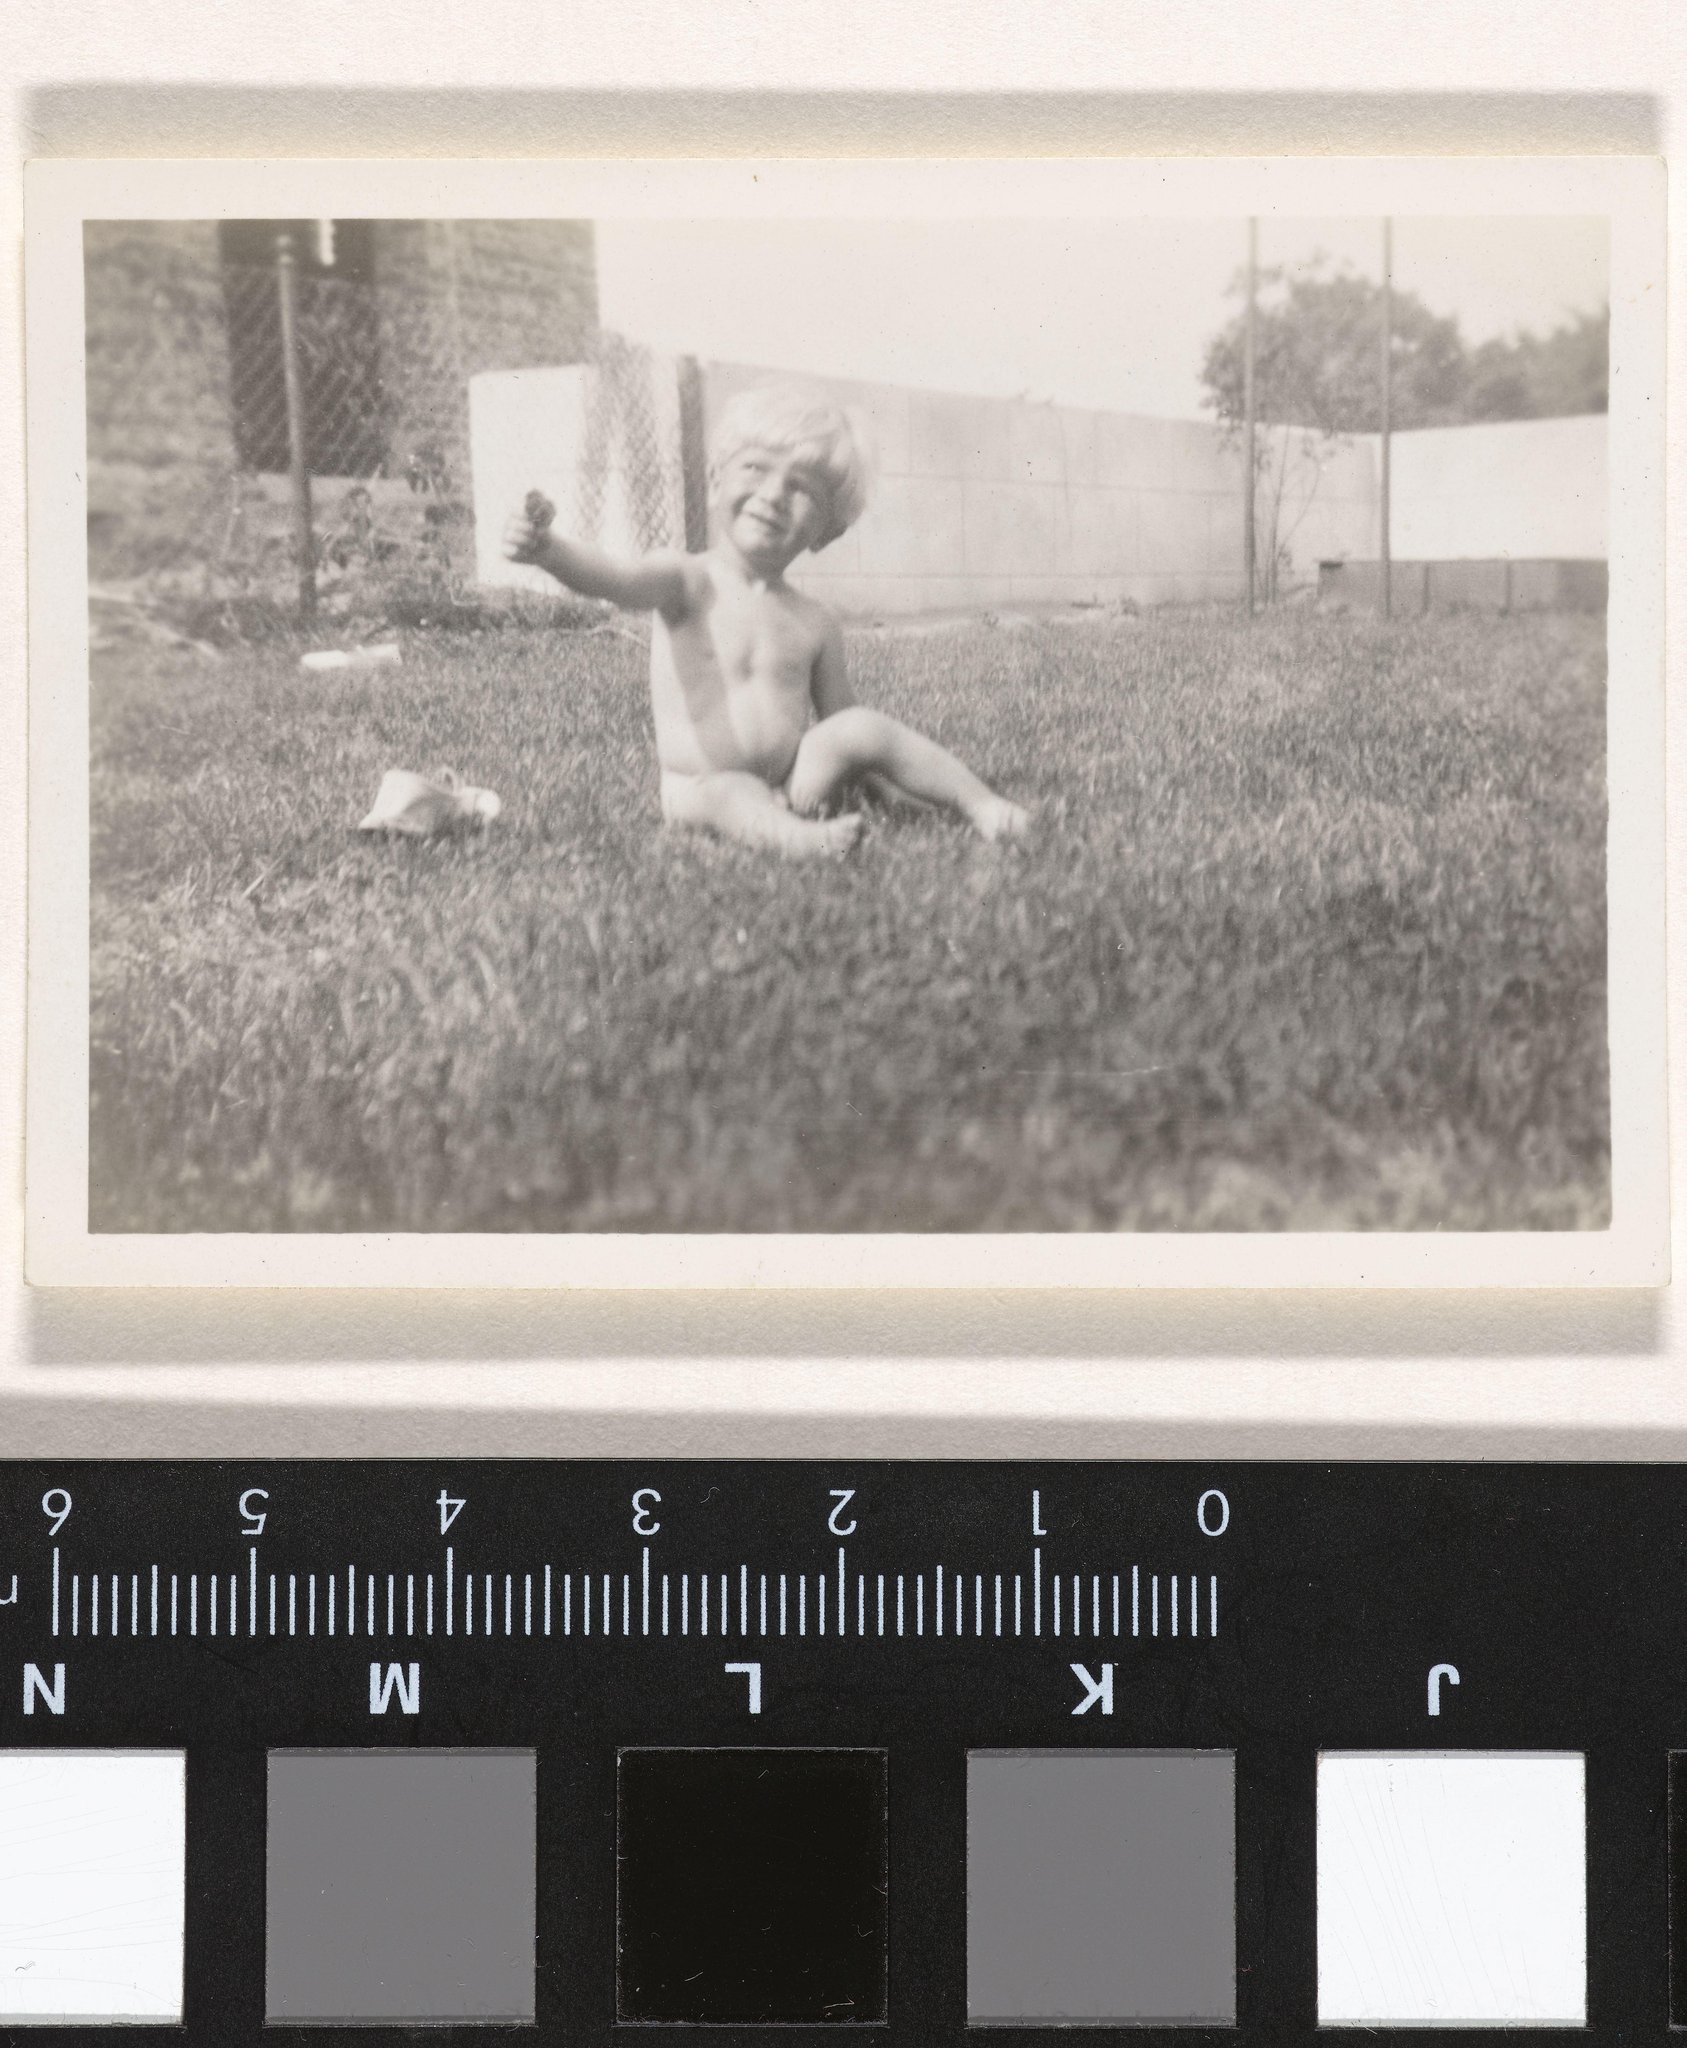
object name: photograph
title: Klein kind zittend in een tuin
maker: Anonymous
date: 1920-1940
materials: paper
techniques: gelatin silver print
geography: germany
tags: tot, toddler ~ the ages of man, germany